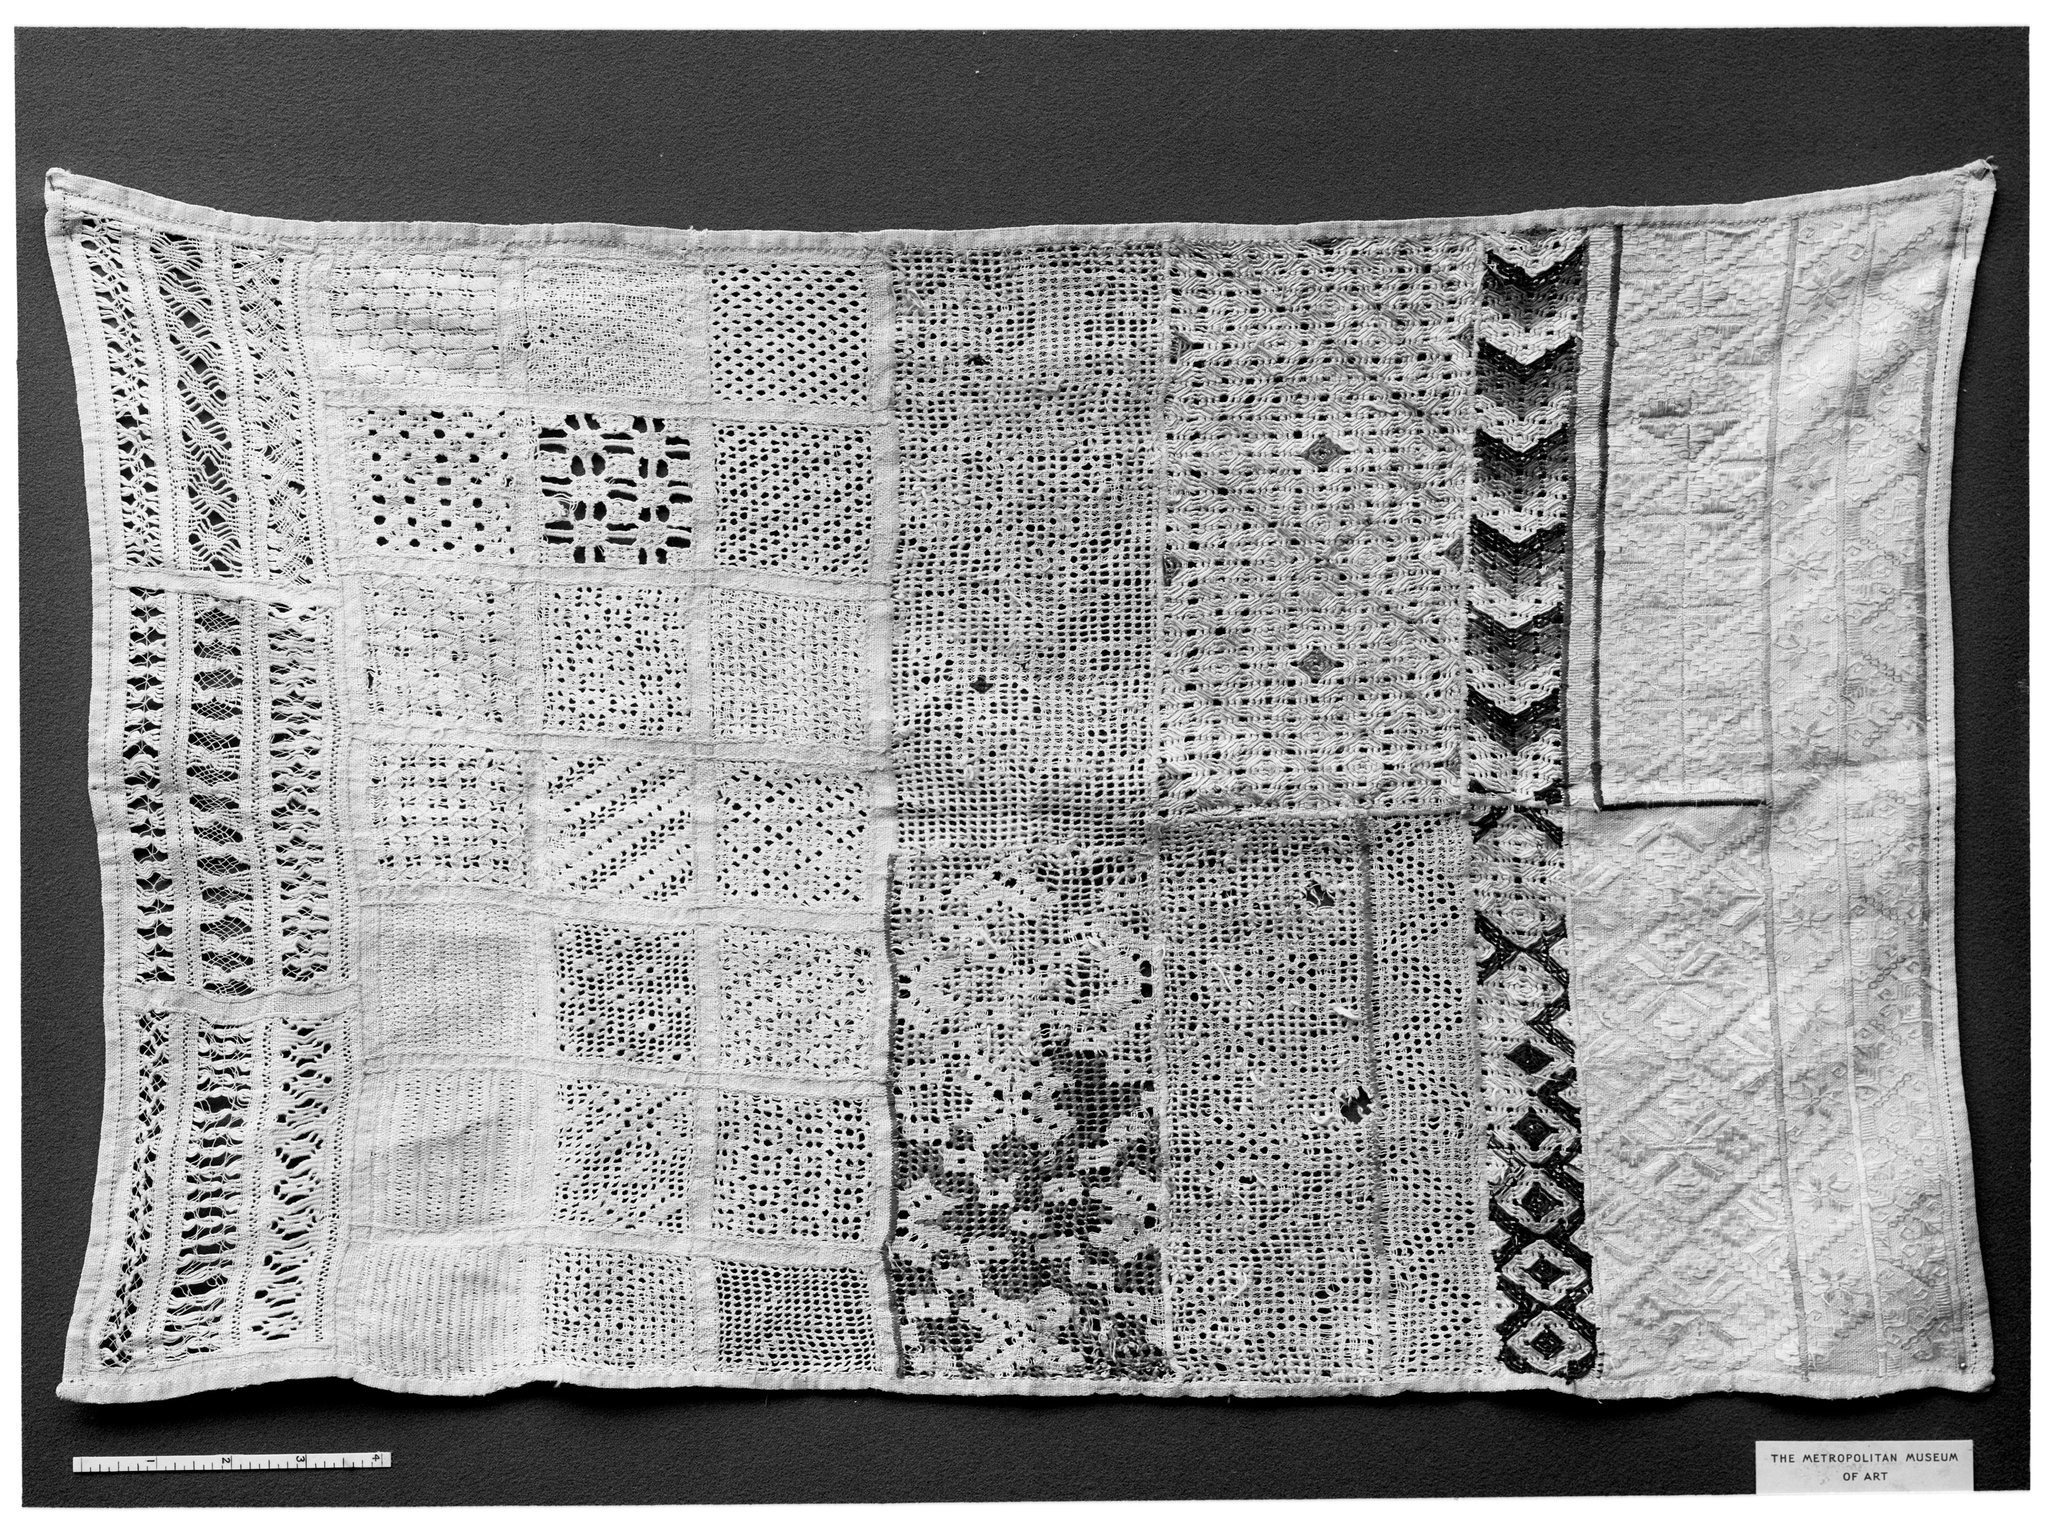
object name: sampler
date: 1701-1800